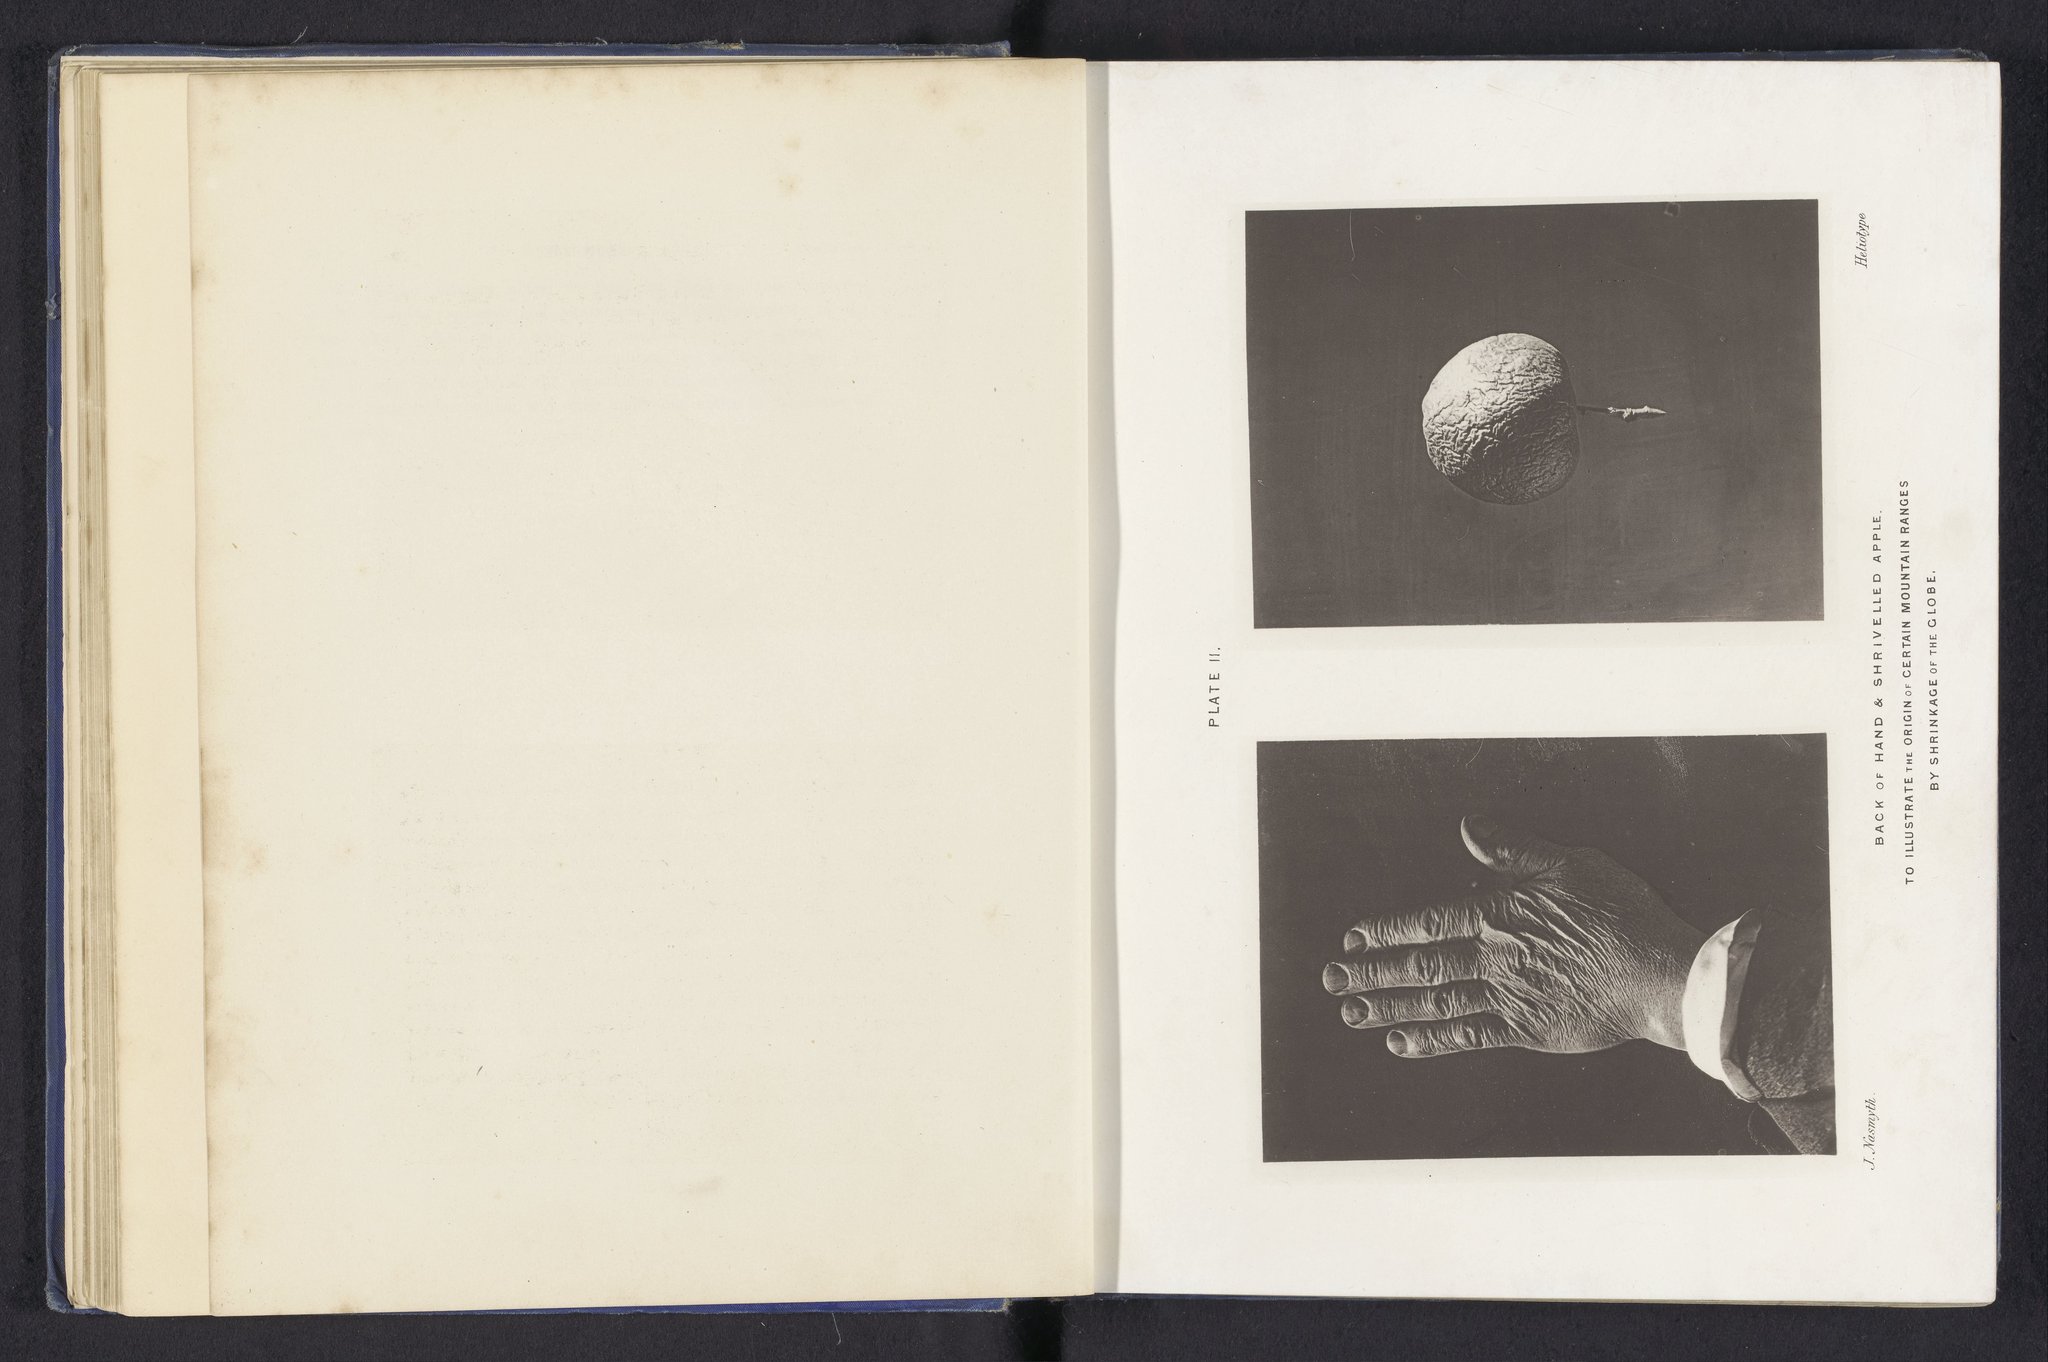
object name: page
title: Back of Hand & Shrivelled Apple. To illustrate the origin of certain mountain ranges by shrinkage of the globe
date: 1870-1873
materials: paper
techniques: photograph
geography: london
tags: fruits: apple, hand (+ back view), united kingdom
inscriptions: number: ‘Plate II.’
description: Links de gerimpelde rug van een hand, rechts een verschrompelde appel.